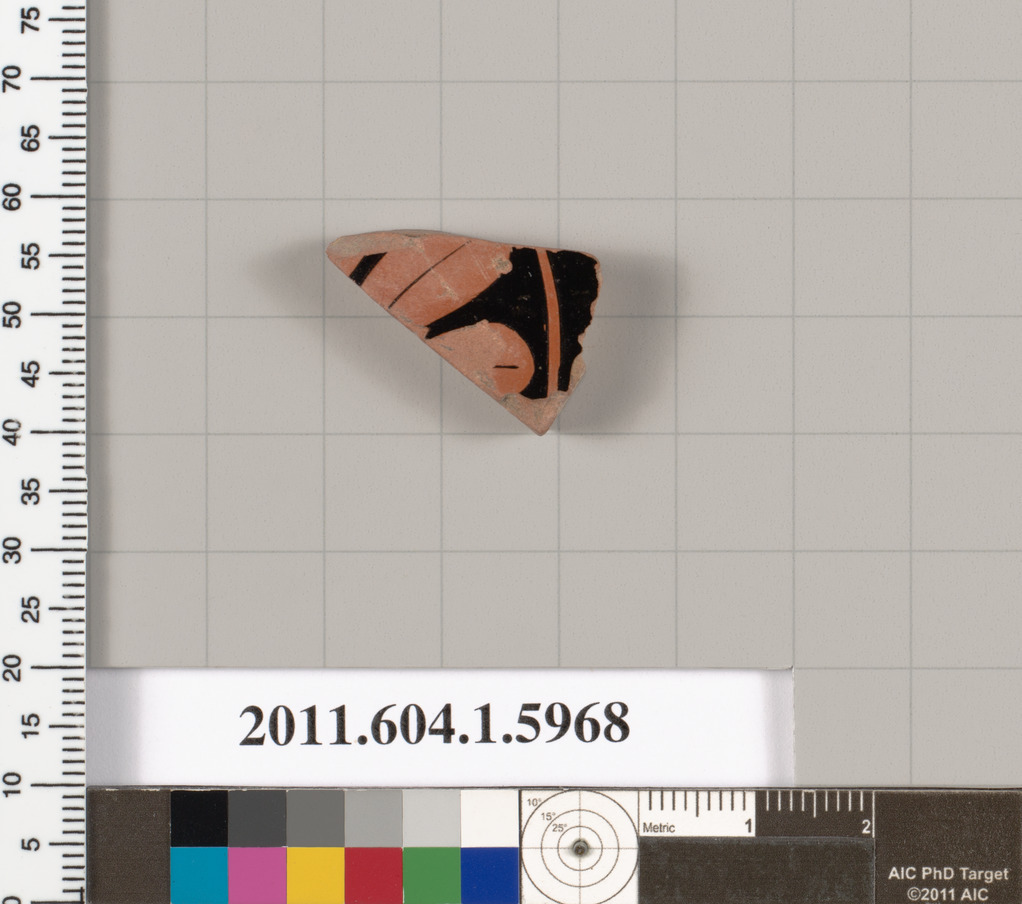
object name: kylix fragment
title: Terracotta fragment of a kylix (drinking cup)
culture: greek, attic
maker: skythes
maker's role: artist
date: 433-567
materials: terracotta